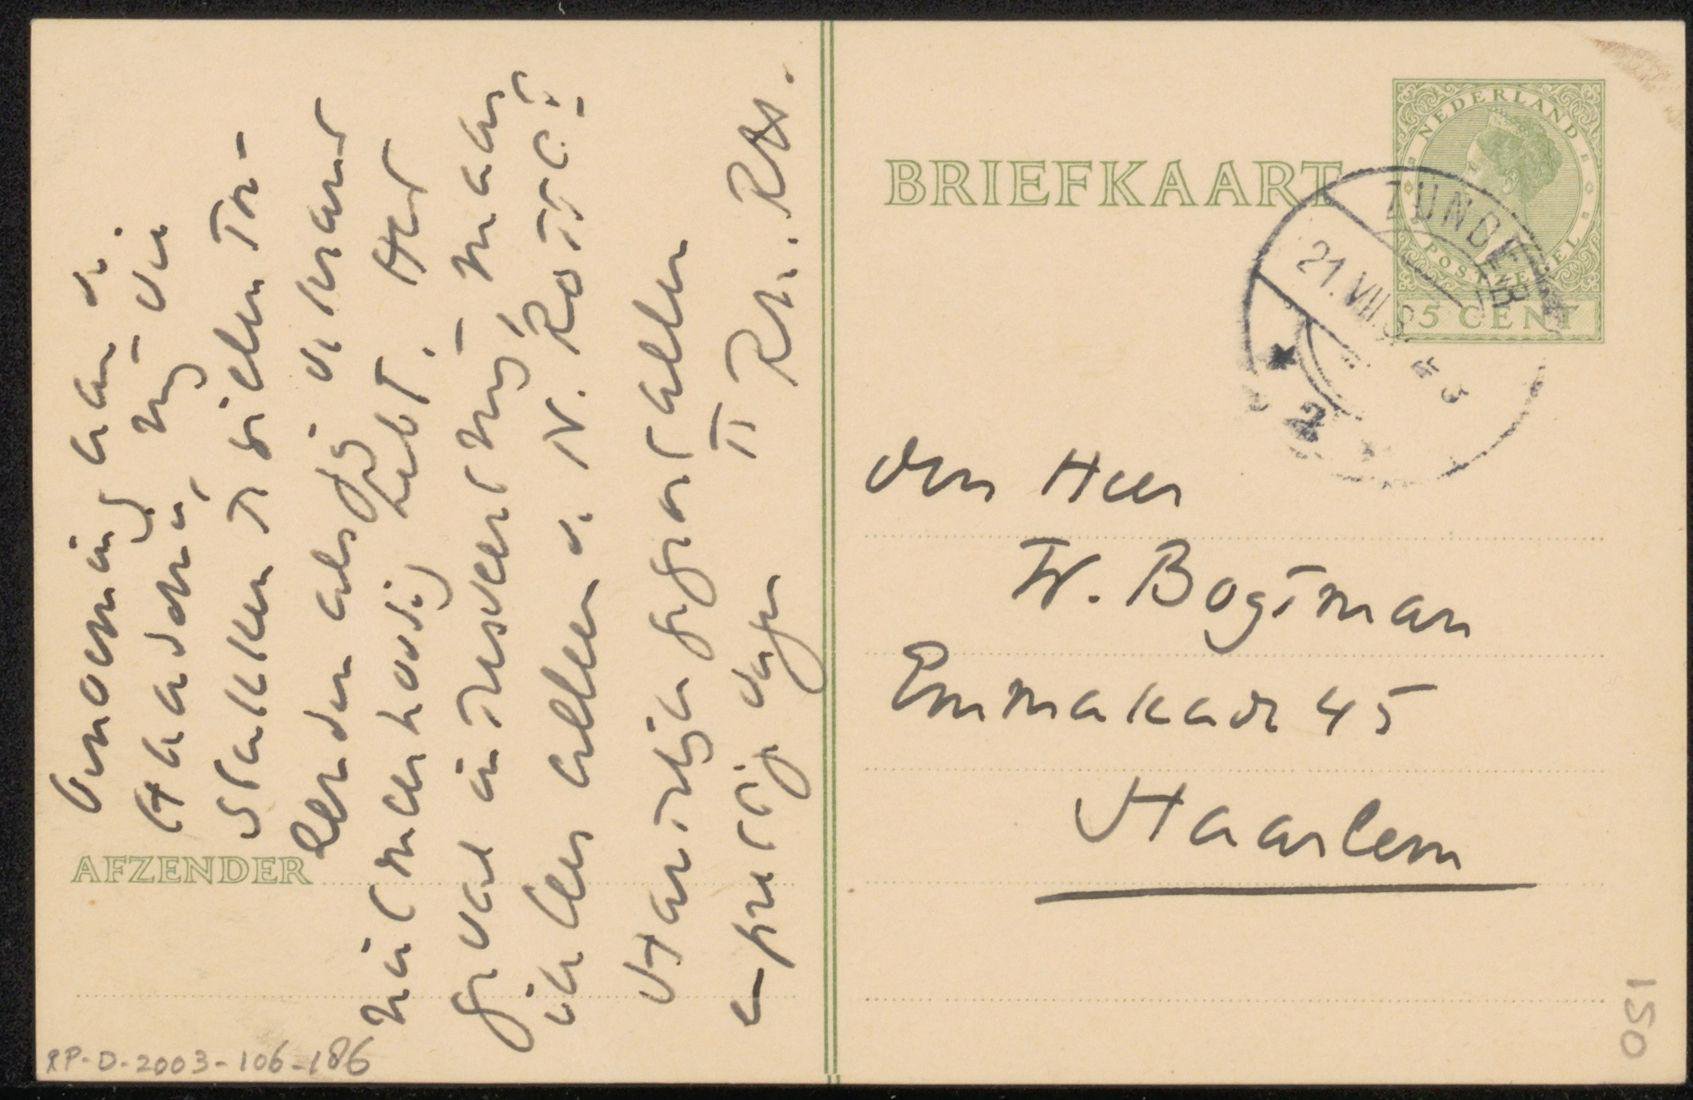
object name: postcard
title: Briefkaart aan Willem Bogtman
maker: richard nicolaüs roland holst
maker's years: 1868-1938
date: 1934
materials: cardboard, ink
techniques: pen, writing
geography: zundert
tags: amsterdam, painter, draughtsman, jaap weyand, haarlem, willem bogtman, applied arts, arts and crafts; industrial design